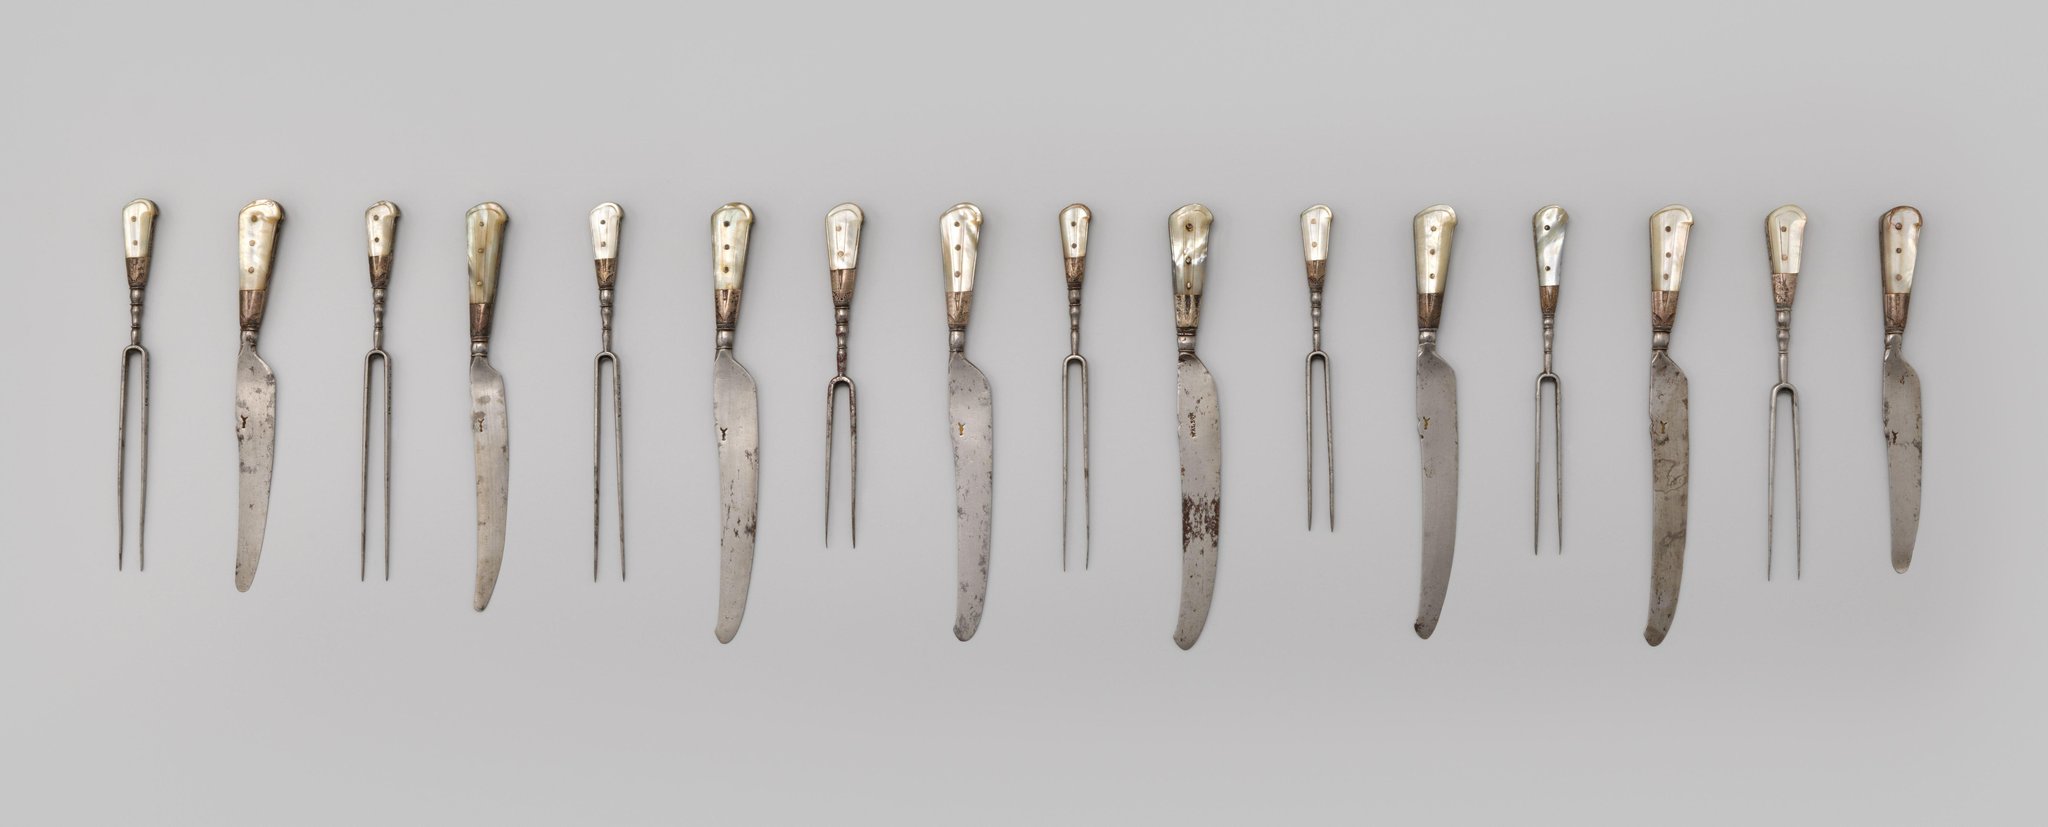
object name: fork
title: Serie van acht messen en vorken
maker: Anonymous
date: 1675-1800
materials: mother of pearl, silver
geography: hungary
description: Serie van 8 messen en vorken met heften van parelmoer en zilver. Op de zilveren montuur een gagraveerde versiering.